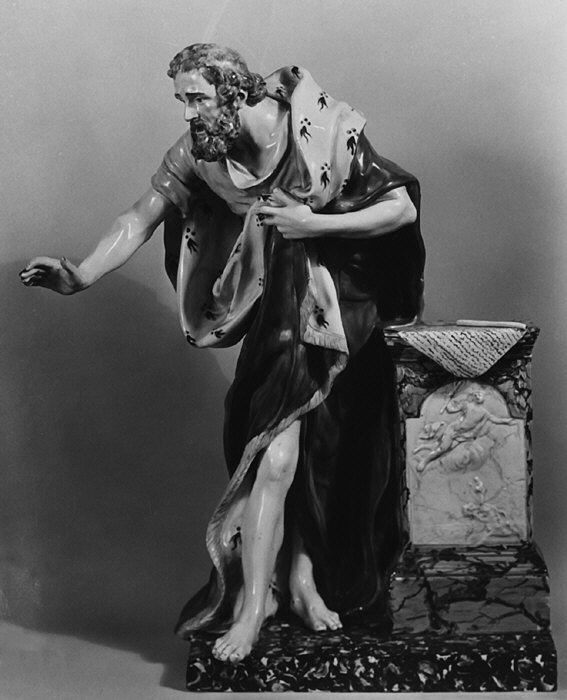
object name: figure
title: Eloquence (also known as St. Paul Preaching at Athens)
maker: enoch wood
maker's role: artist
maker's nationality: british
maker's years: 1759-1846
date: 1787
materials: earthenware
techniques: glazing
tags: saint paul